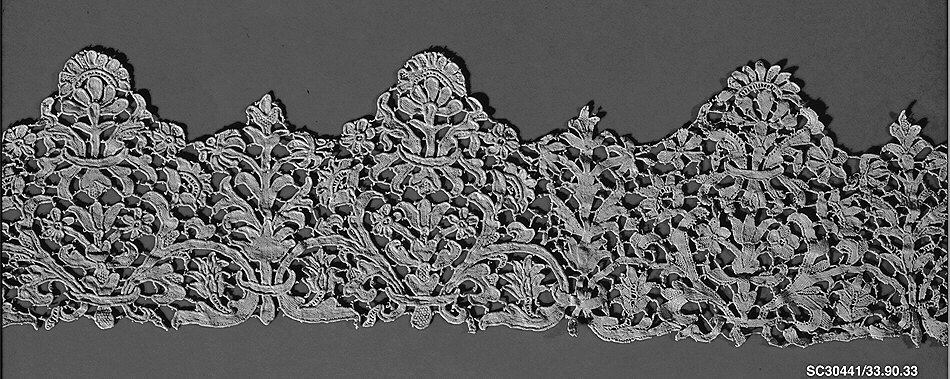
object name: edging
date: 1601-1700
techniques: lace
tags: flowers